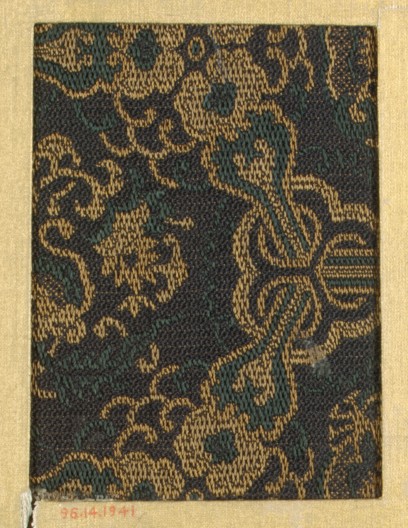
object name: piece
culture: japanese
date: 1701-1900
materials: silk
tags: flowers